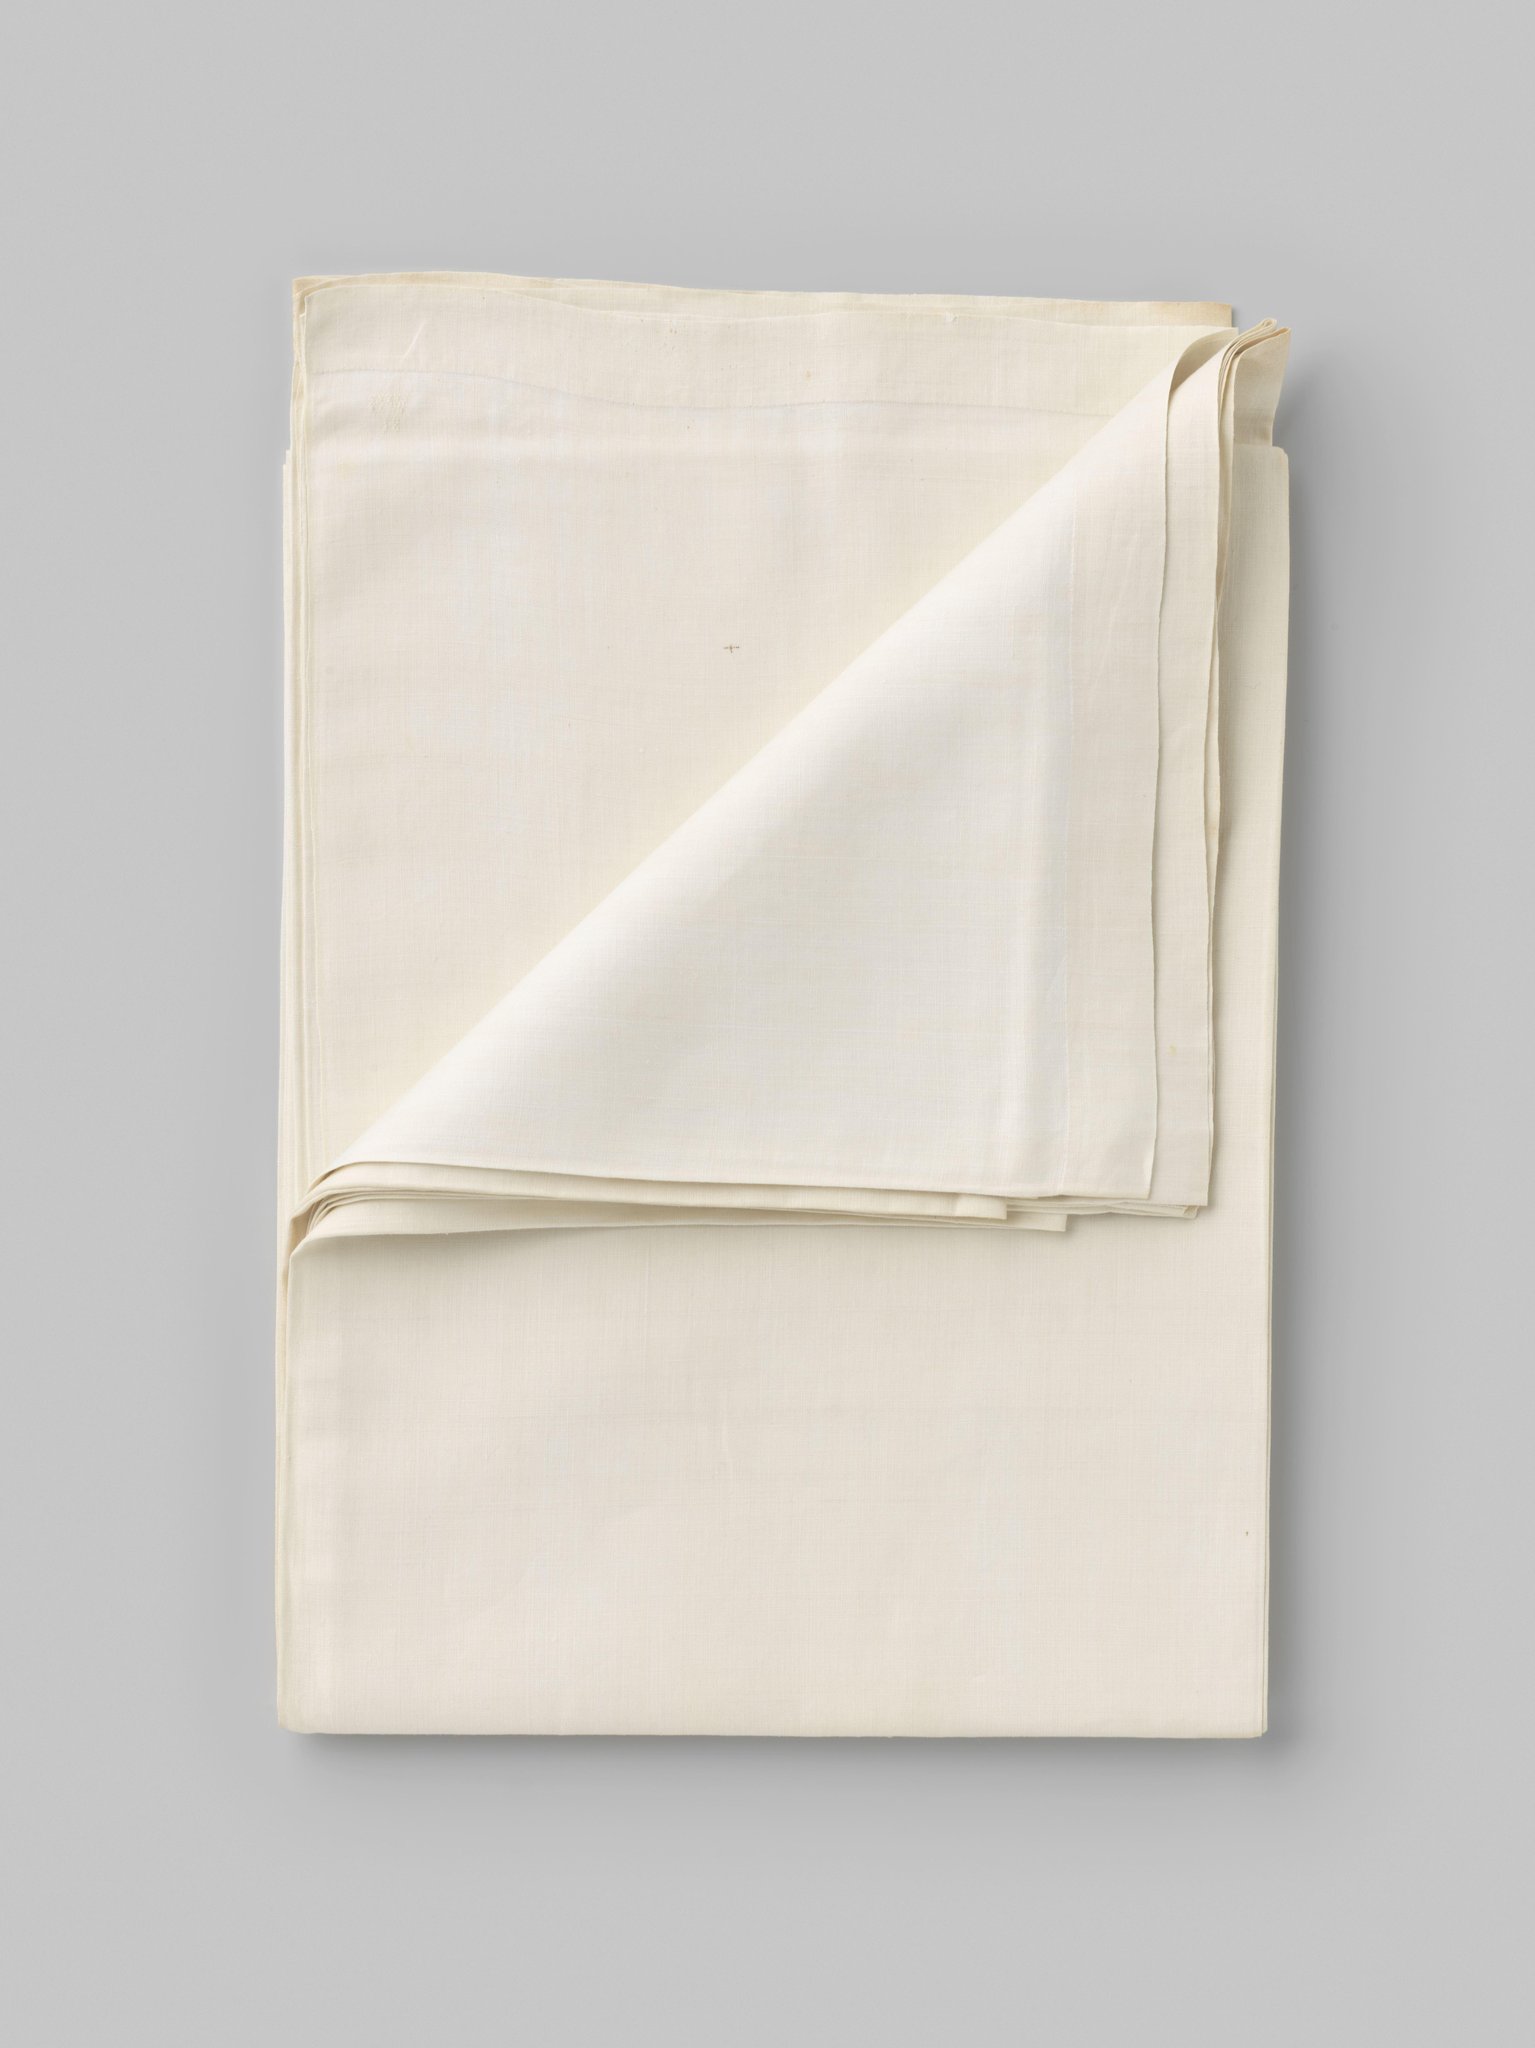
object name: beddenlaken, laken object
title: Laken. Merk: HW 182.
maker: Anonymous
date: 1831-1872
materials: linen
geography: northern netherlands